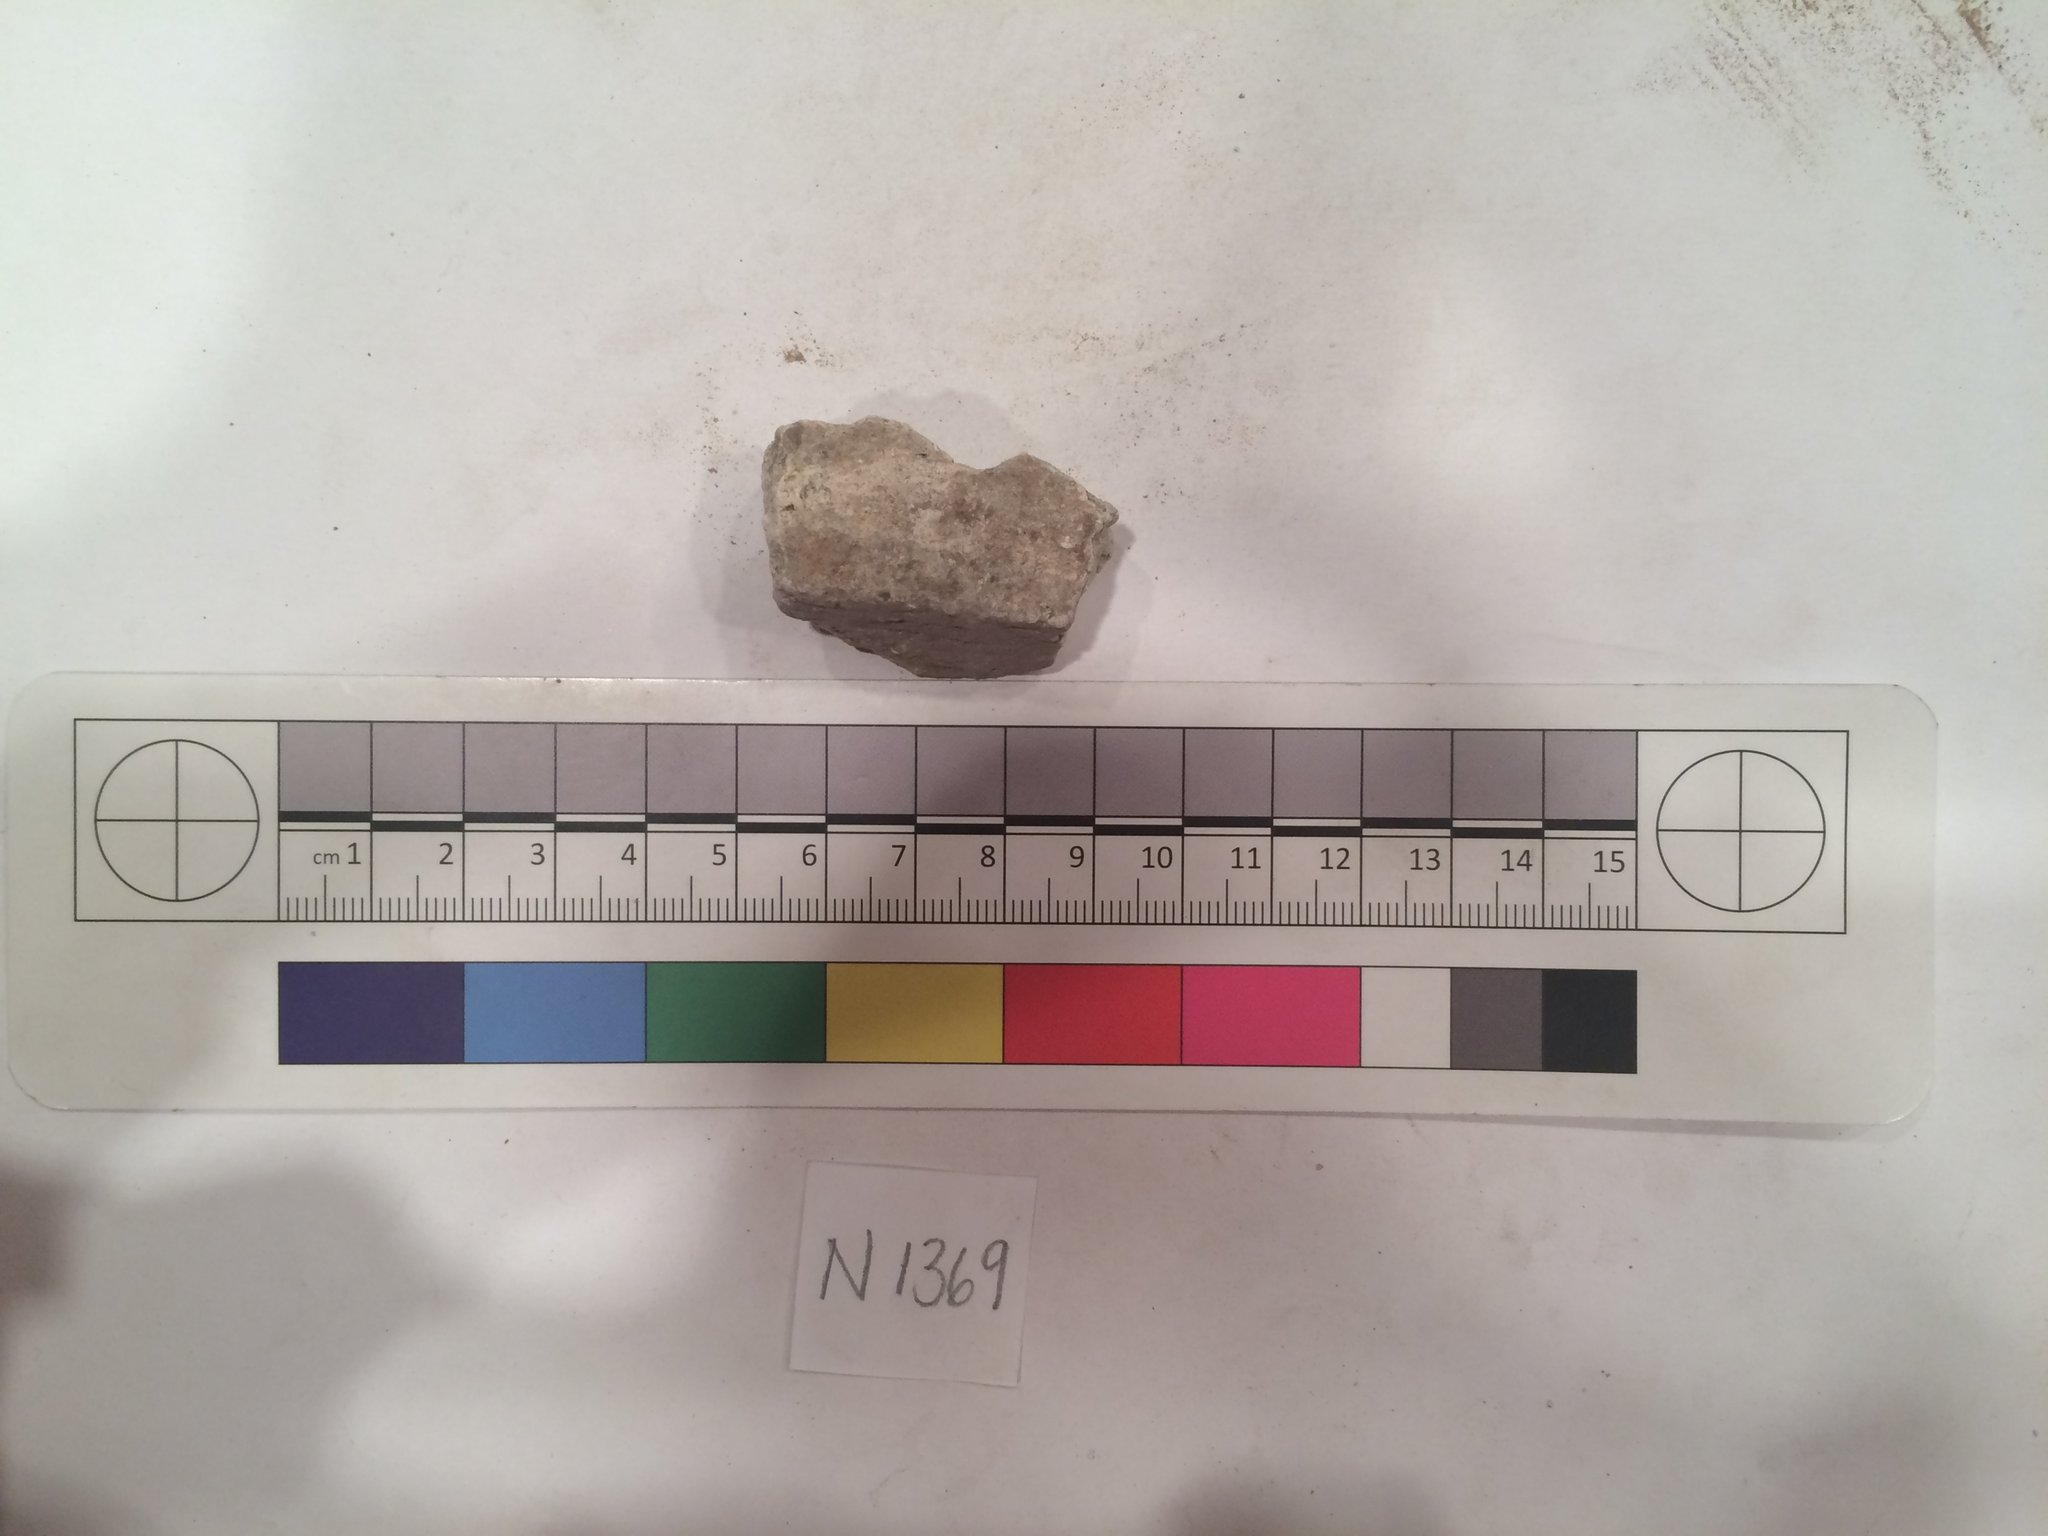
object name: fragment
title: Stucco Fragment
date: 701-1200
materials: plaster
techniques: carving, painting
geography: iran